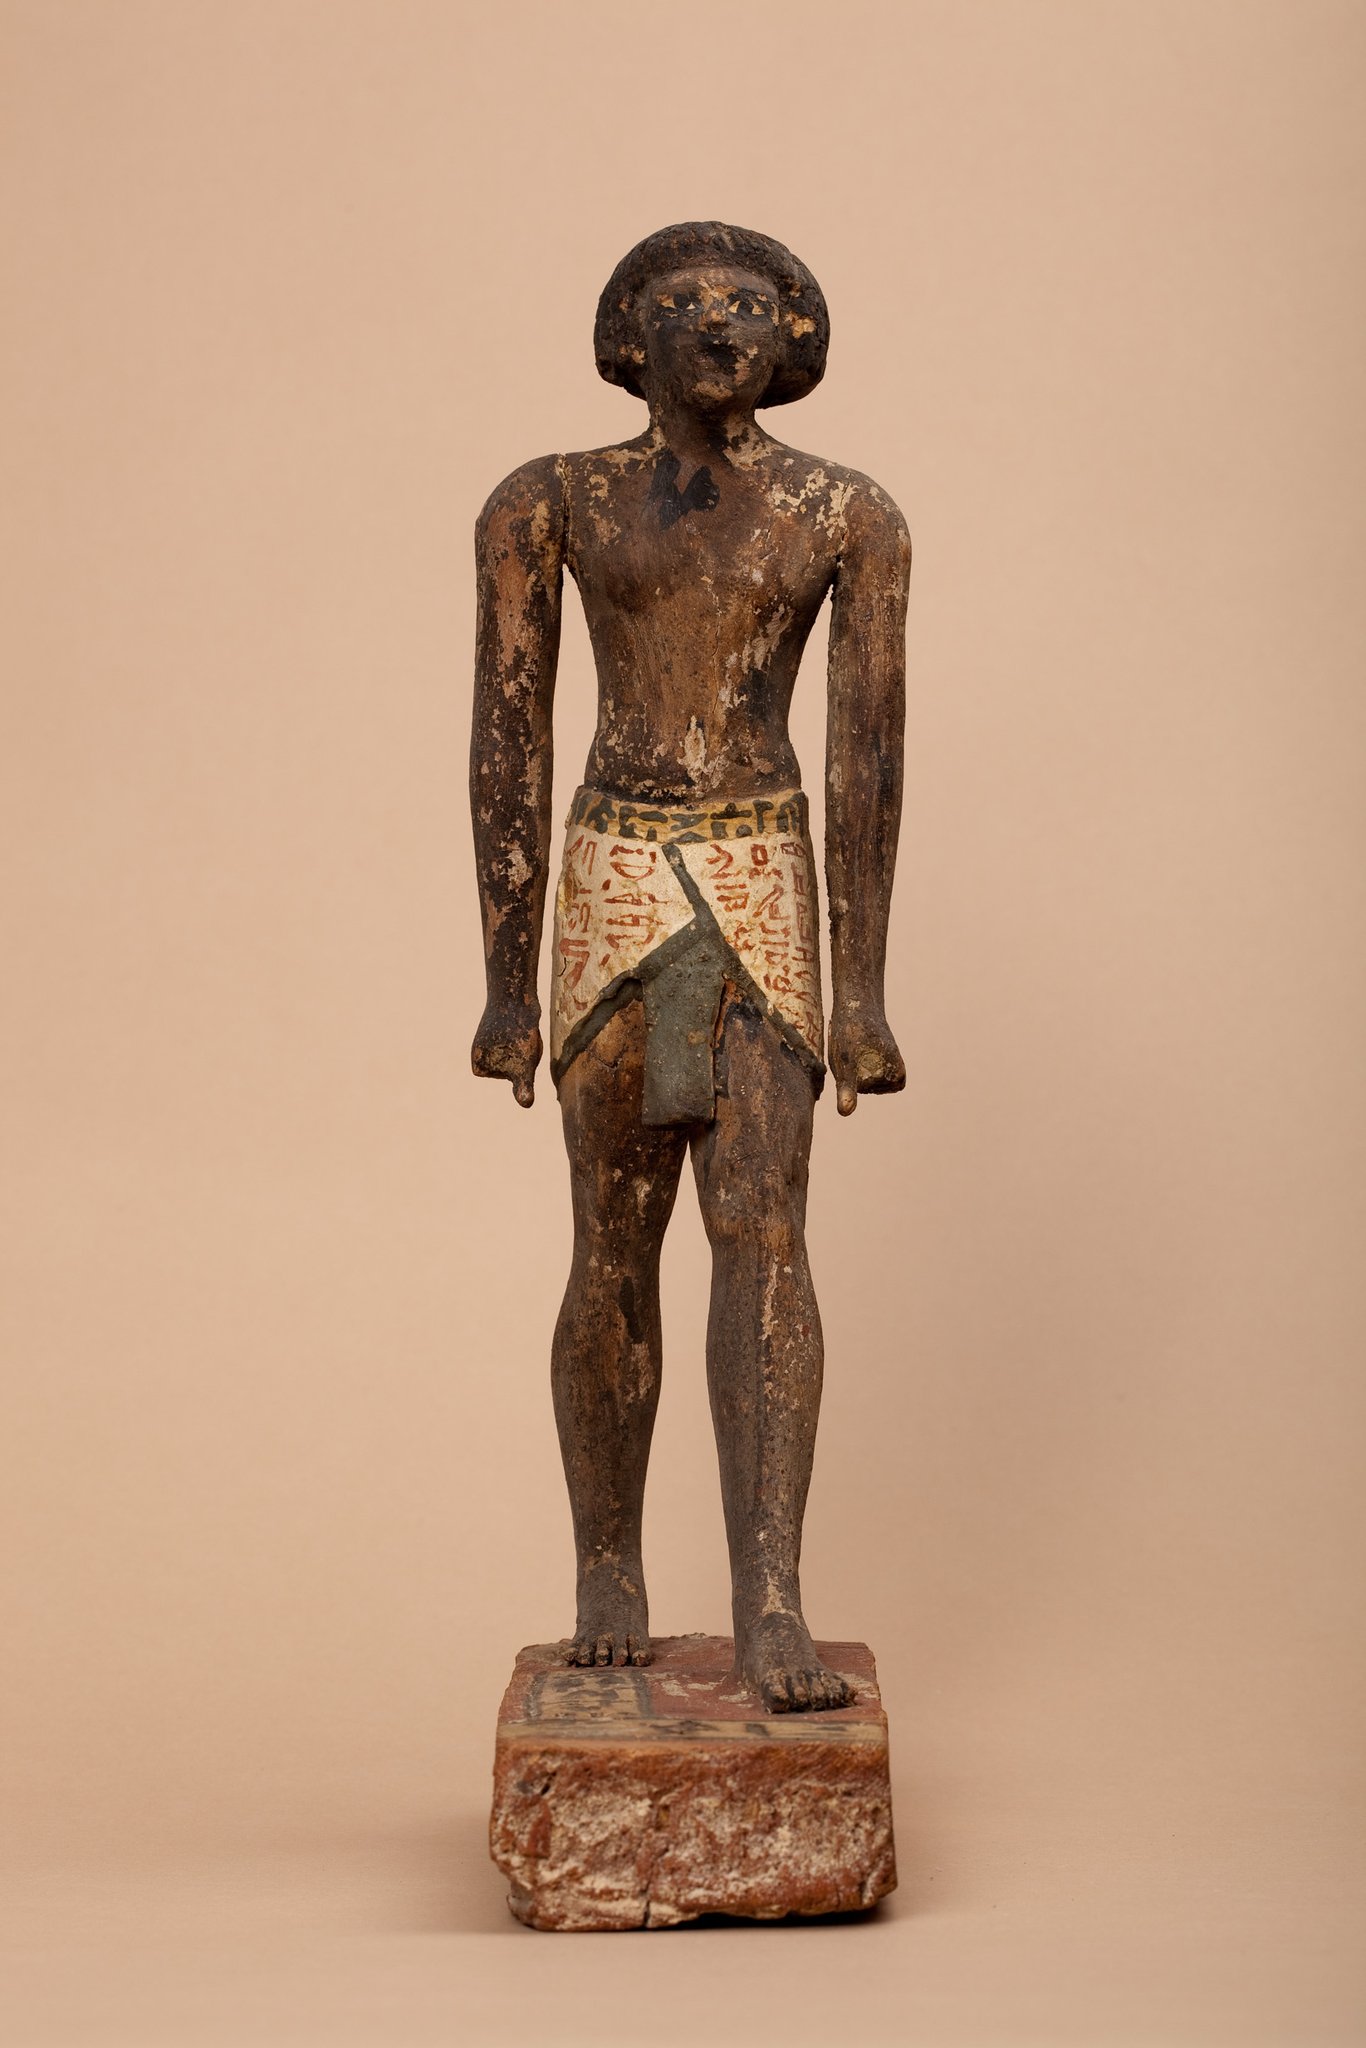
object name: statuette, merer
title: Statuette of Merer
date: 1981-1802 BCE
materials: paint, wood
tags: men,hieroglyphs